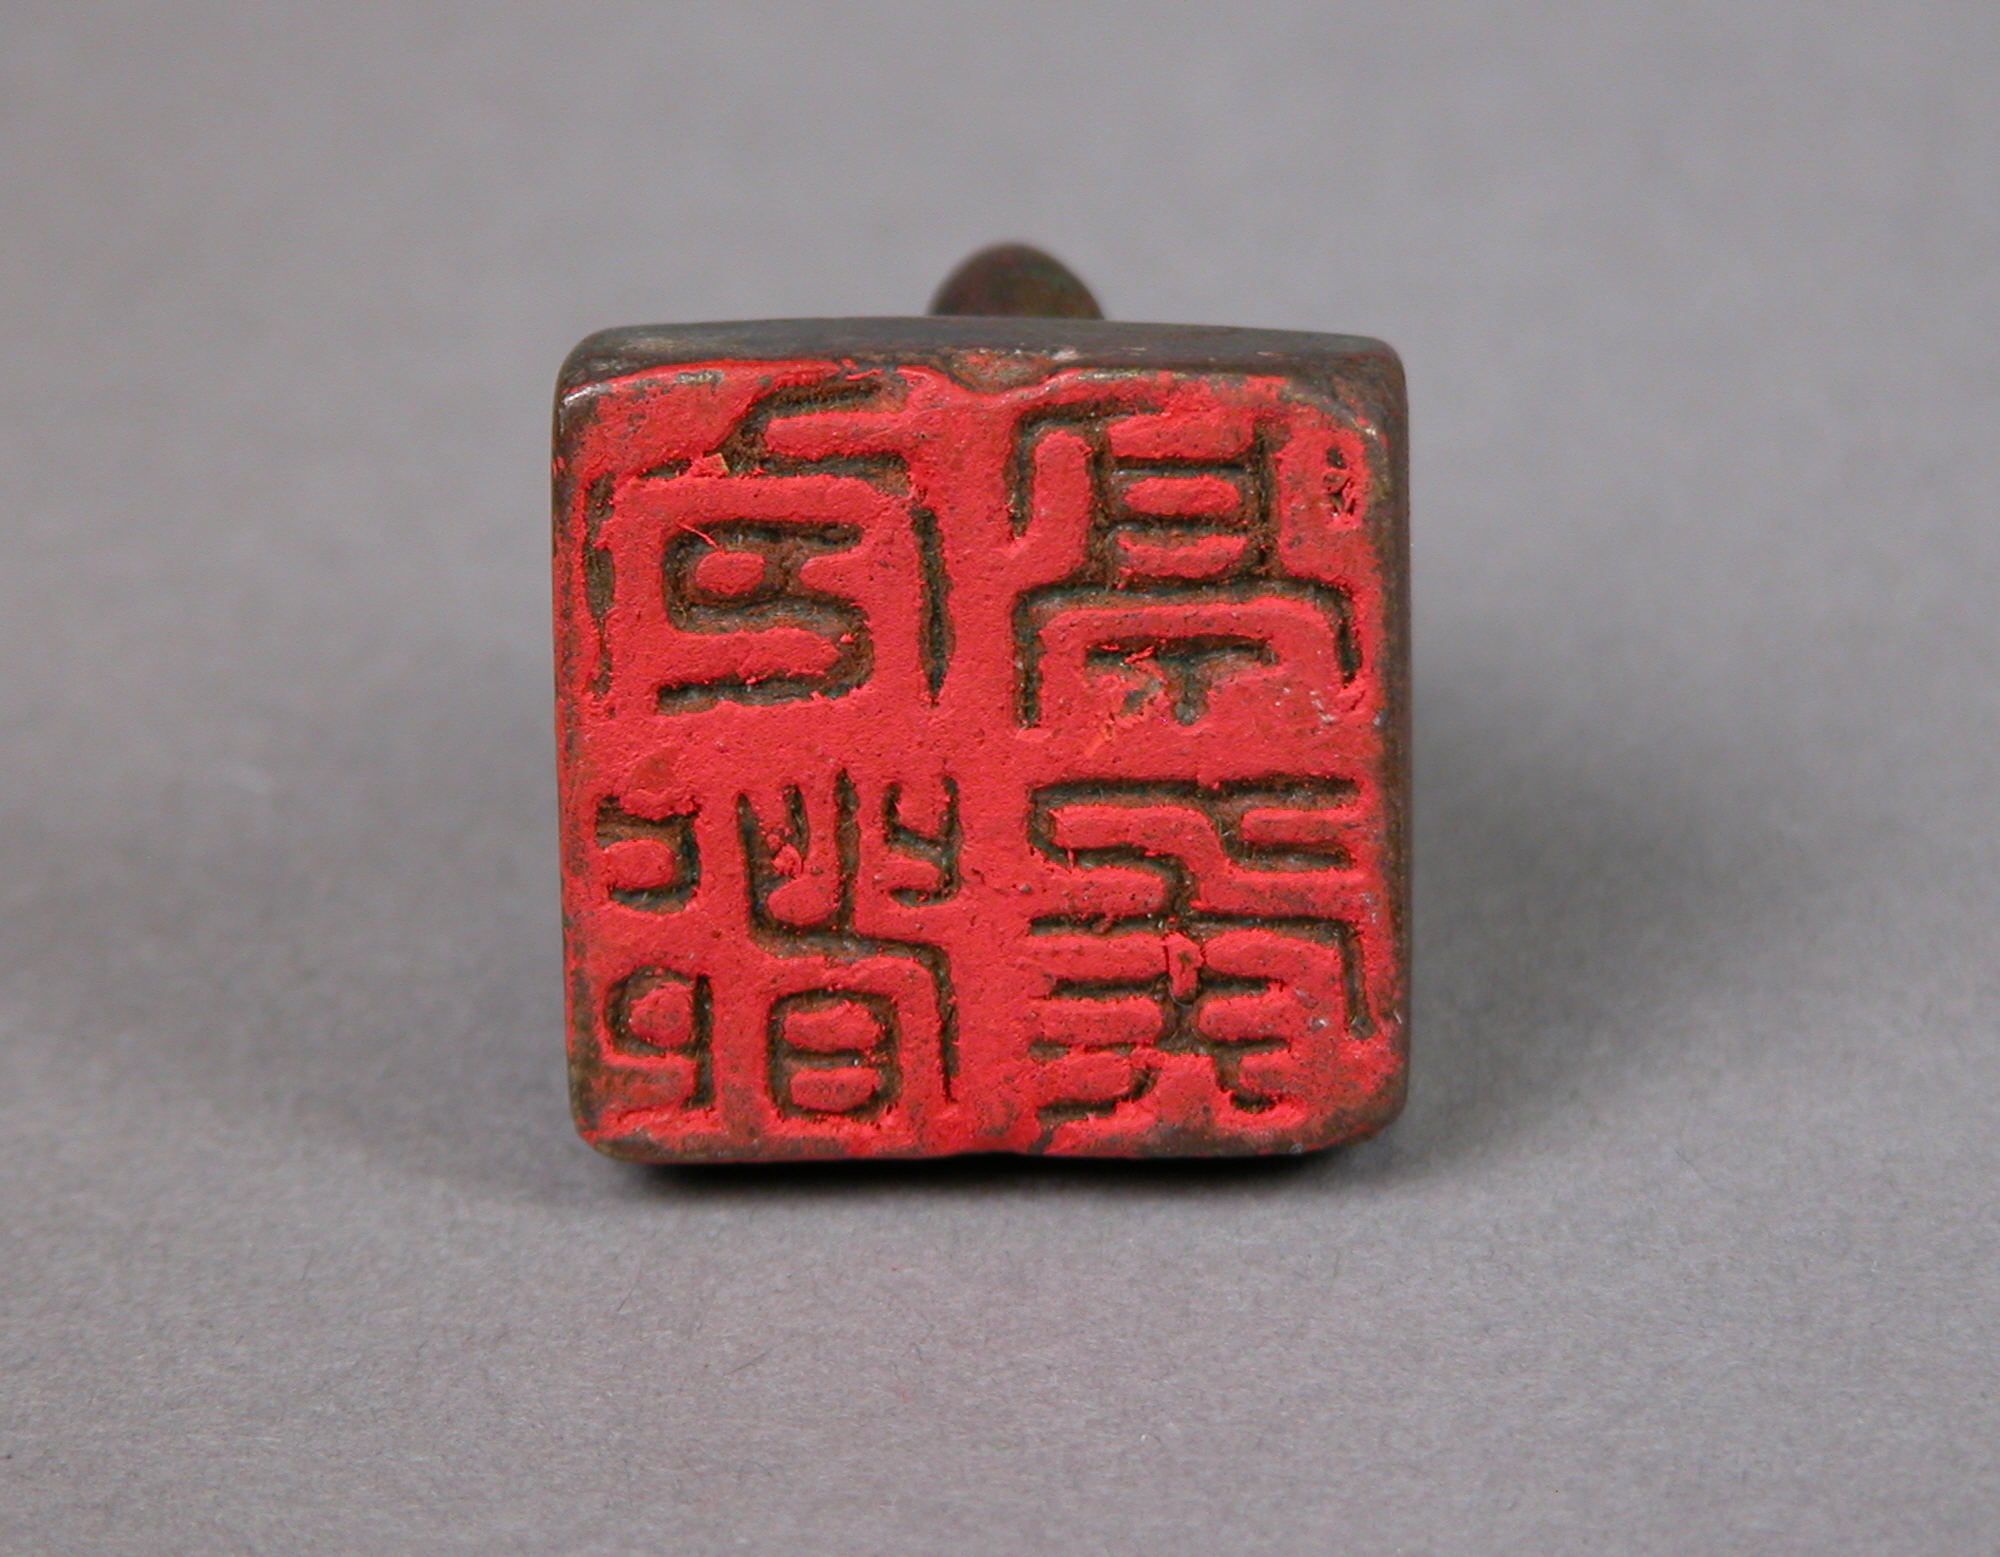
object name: seal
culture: chinese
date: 1300-1644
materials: bronze